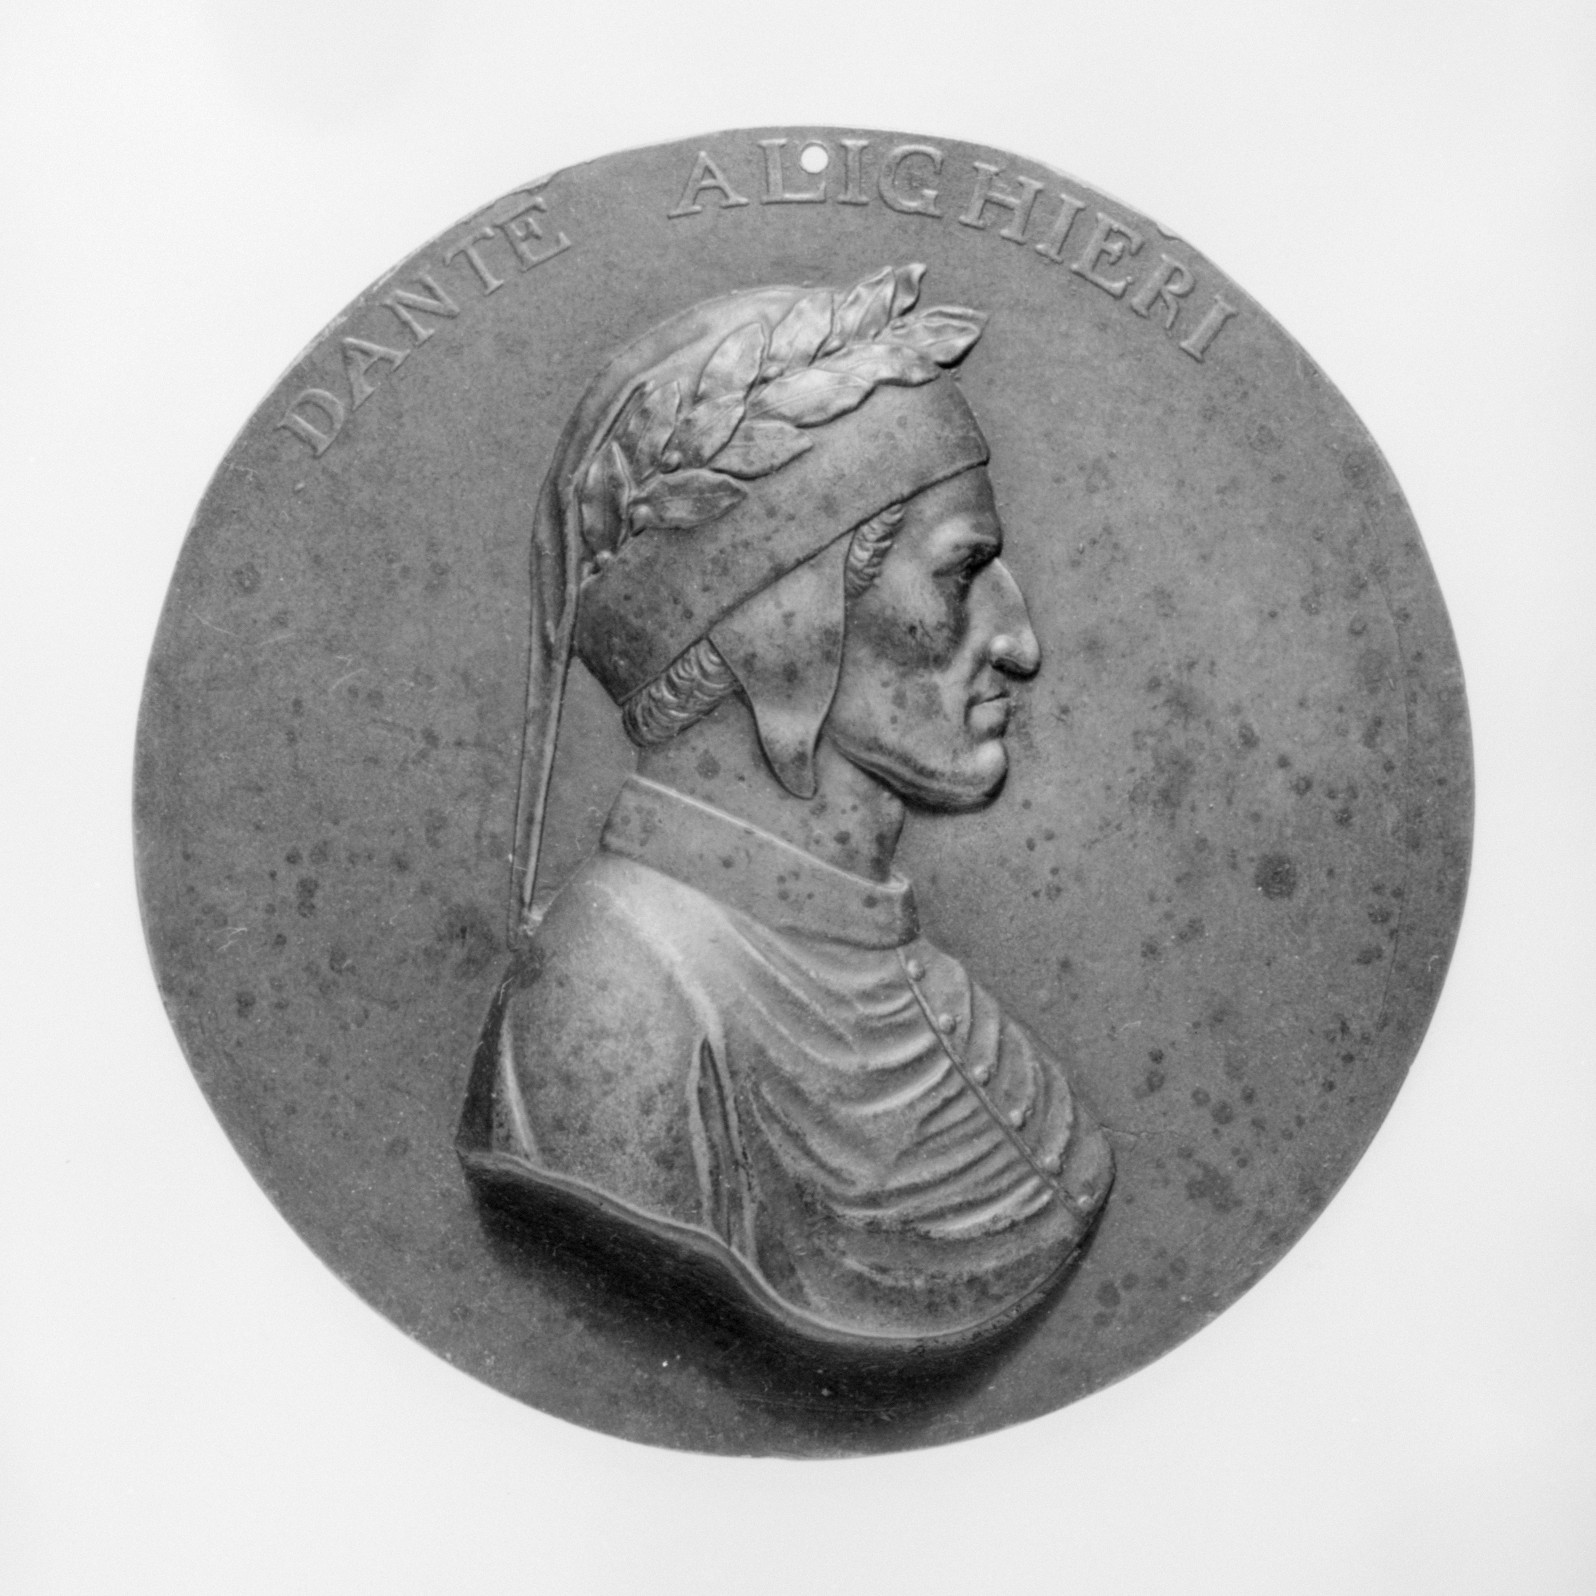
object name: medallion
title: Dante Alighieri (1265–1321)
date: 1701-1900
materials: bronze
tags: men,profiles